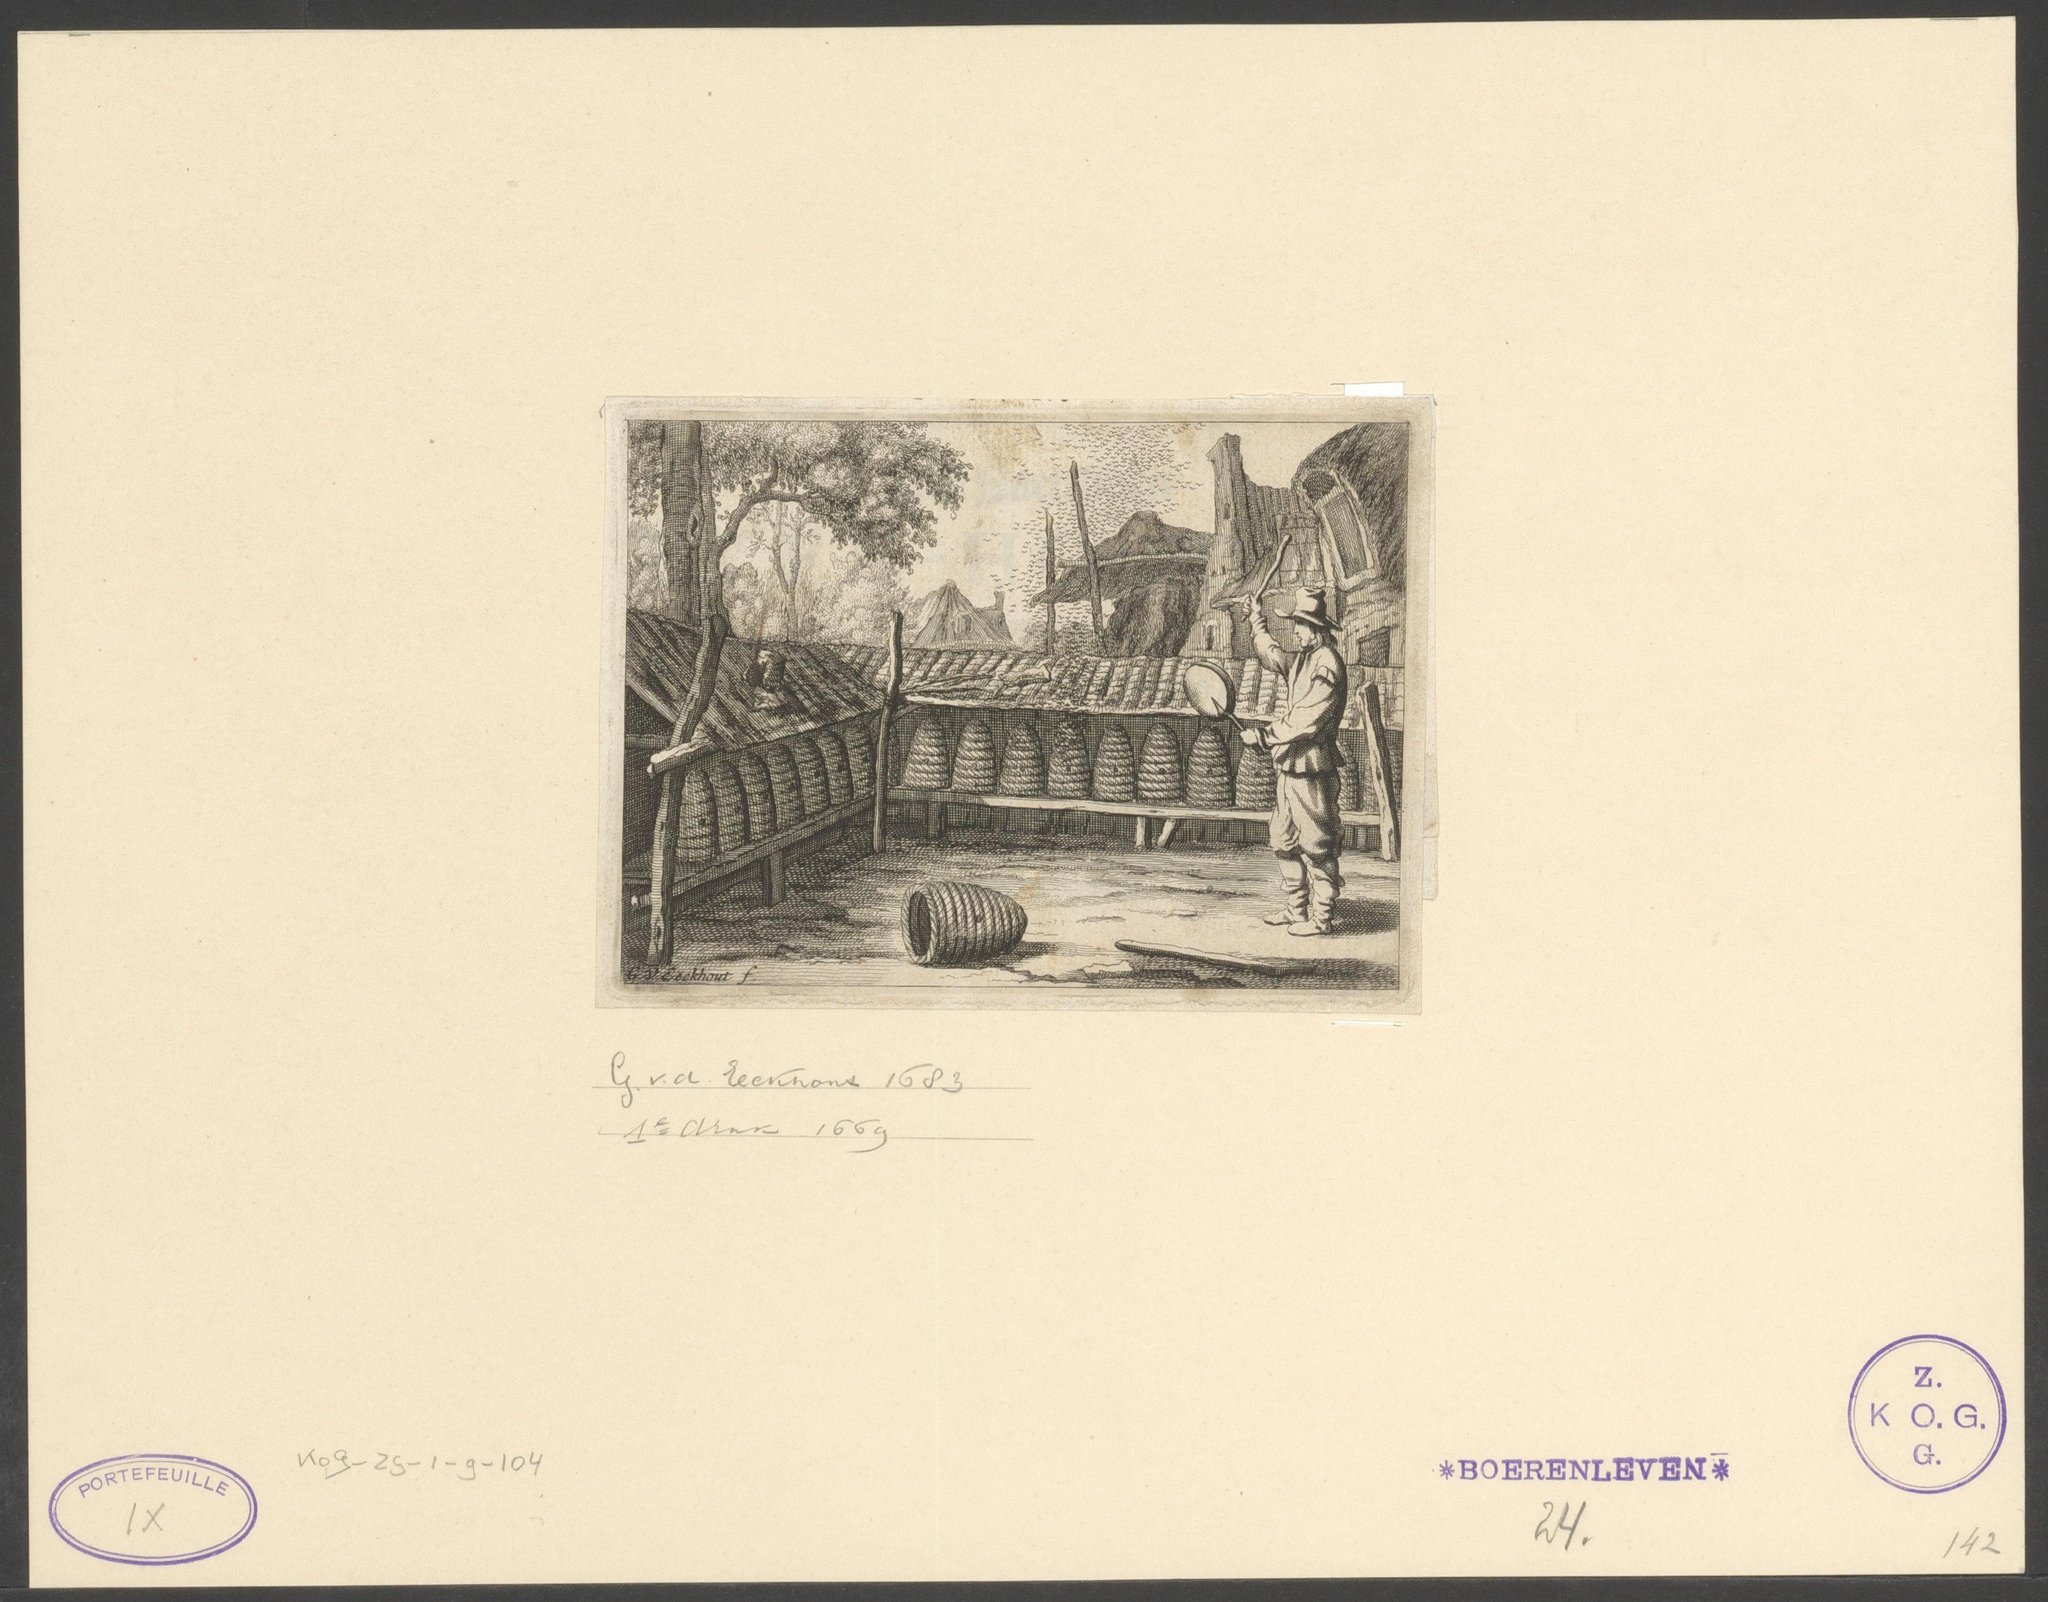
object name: print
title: Imker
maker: gerbrand van den eeckhout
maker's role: draughtsman, print maker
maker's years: 1621-1674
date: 1669-1711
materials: paper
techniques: etching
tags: bee-hive, bee-keeper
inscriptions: stamp, collector's mark: Lugt 1641, stamp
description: Prent gebruikt in verschillende edities van: Het vermakelijck Landt-Leven. Prent mogelijk uit: Nyland, P. Den Erbaren Huys-houder; Zijnde het II. Deel van het Vermakelyck landt-leven (...) Naerstigen Byen-houder. Amsterdam: Marcus Doornick, 1669. Of uit latere publicaties (1670, 1683, 1686, 1711).